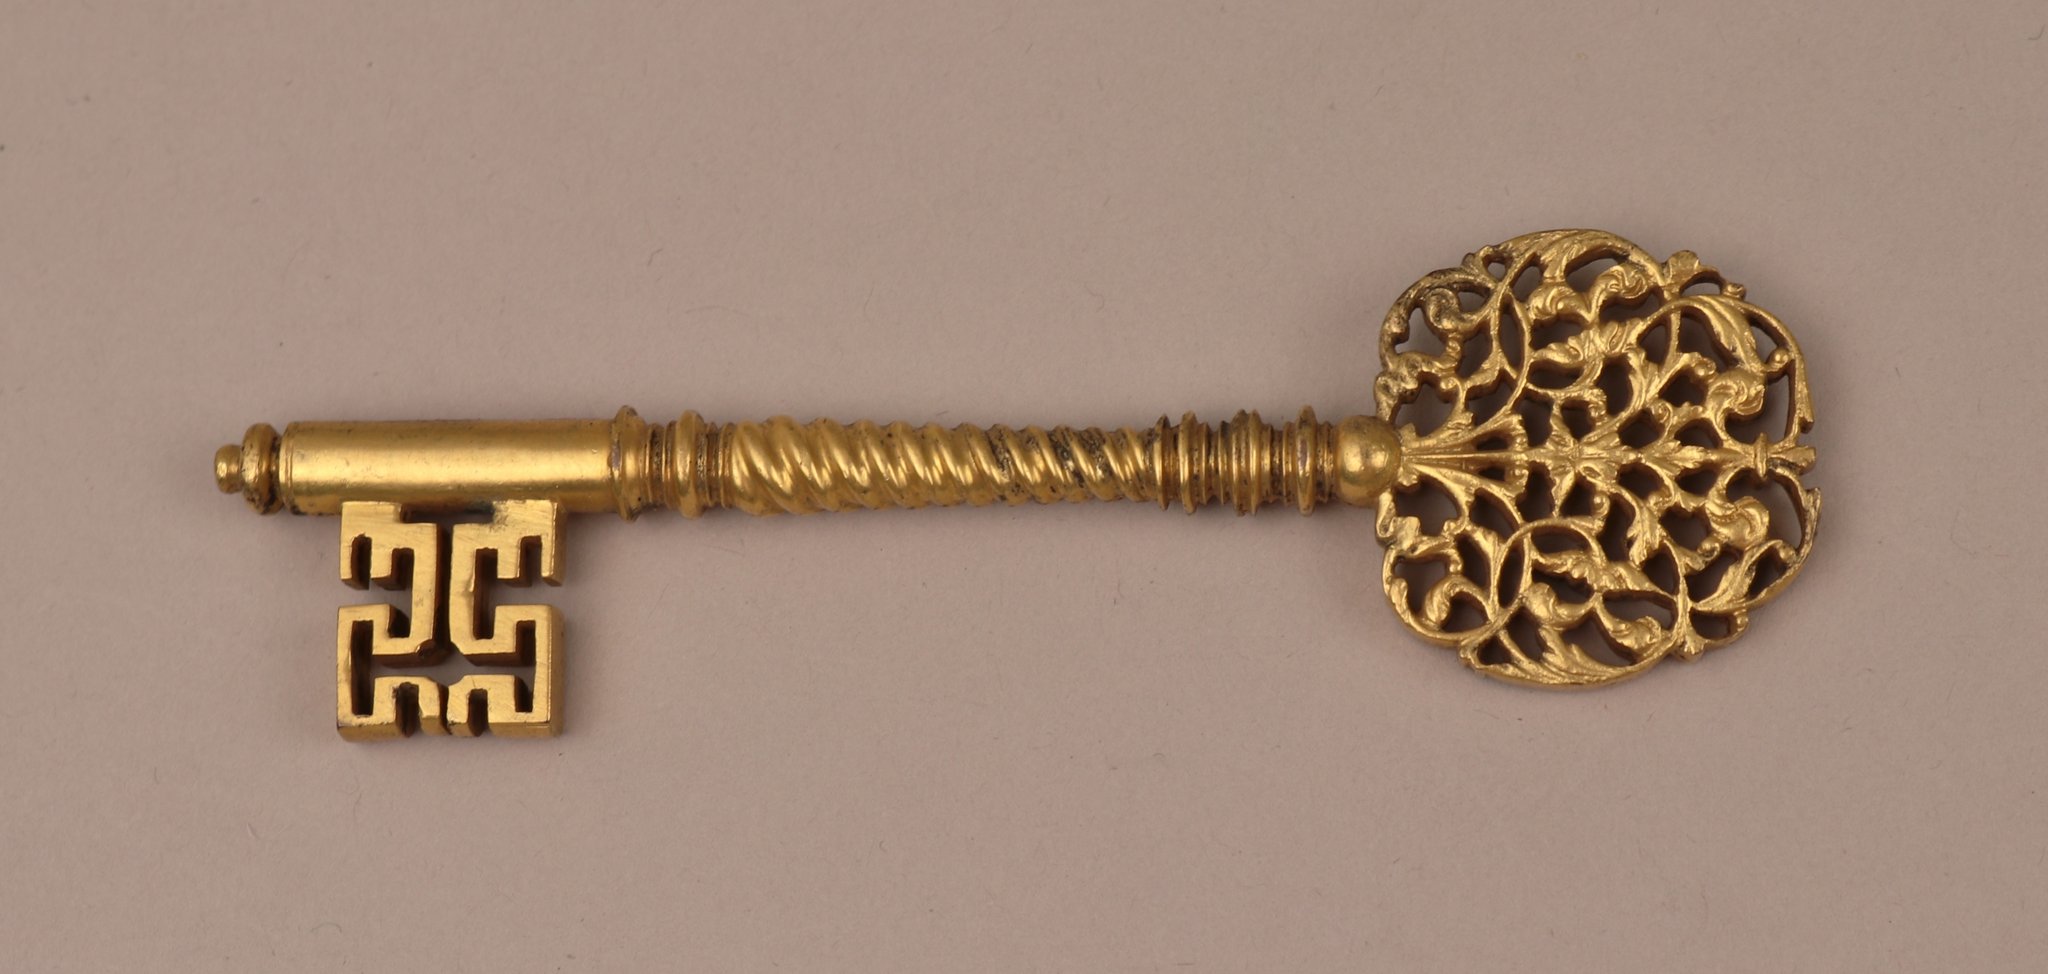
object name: key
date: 1801-1900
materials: steel